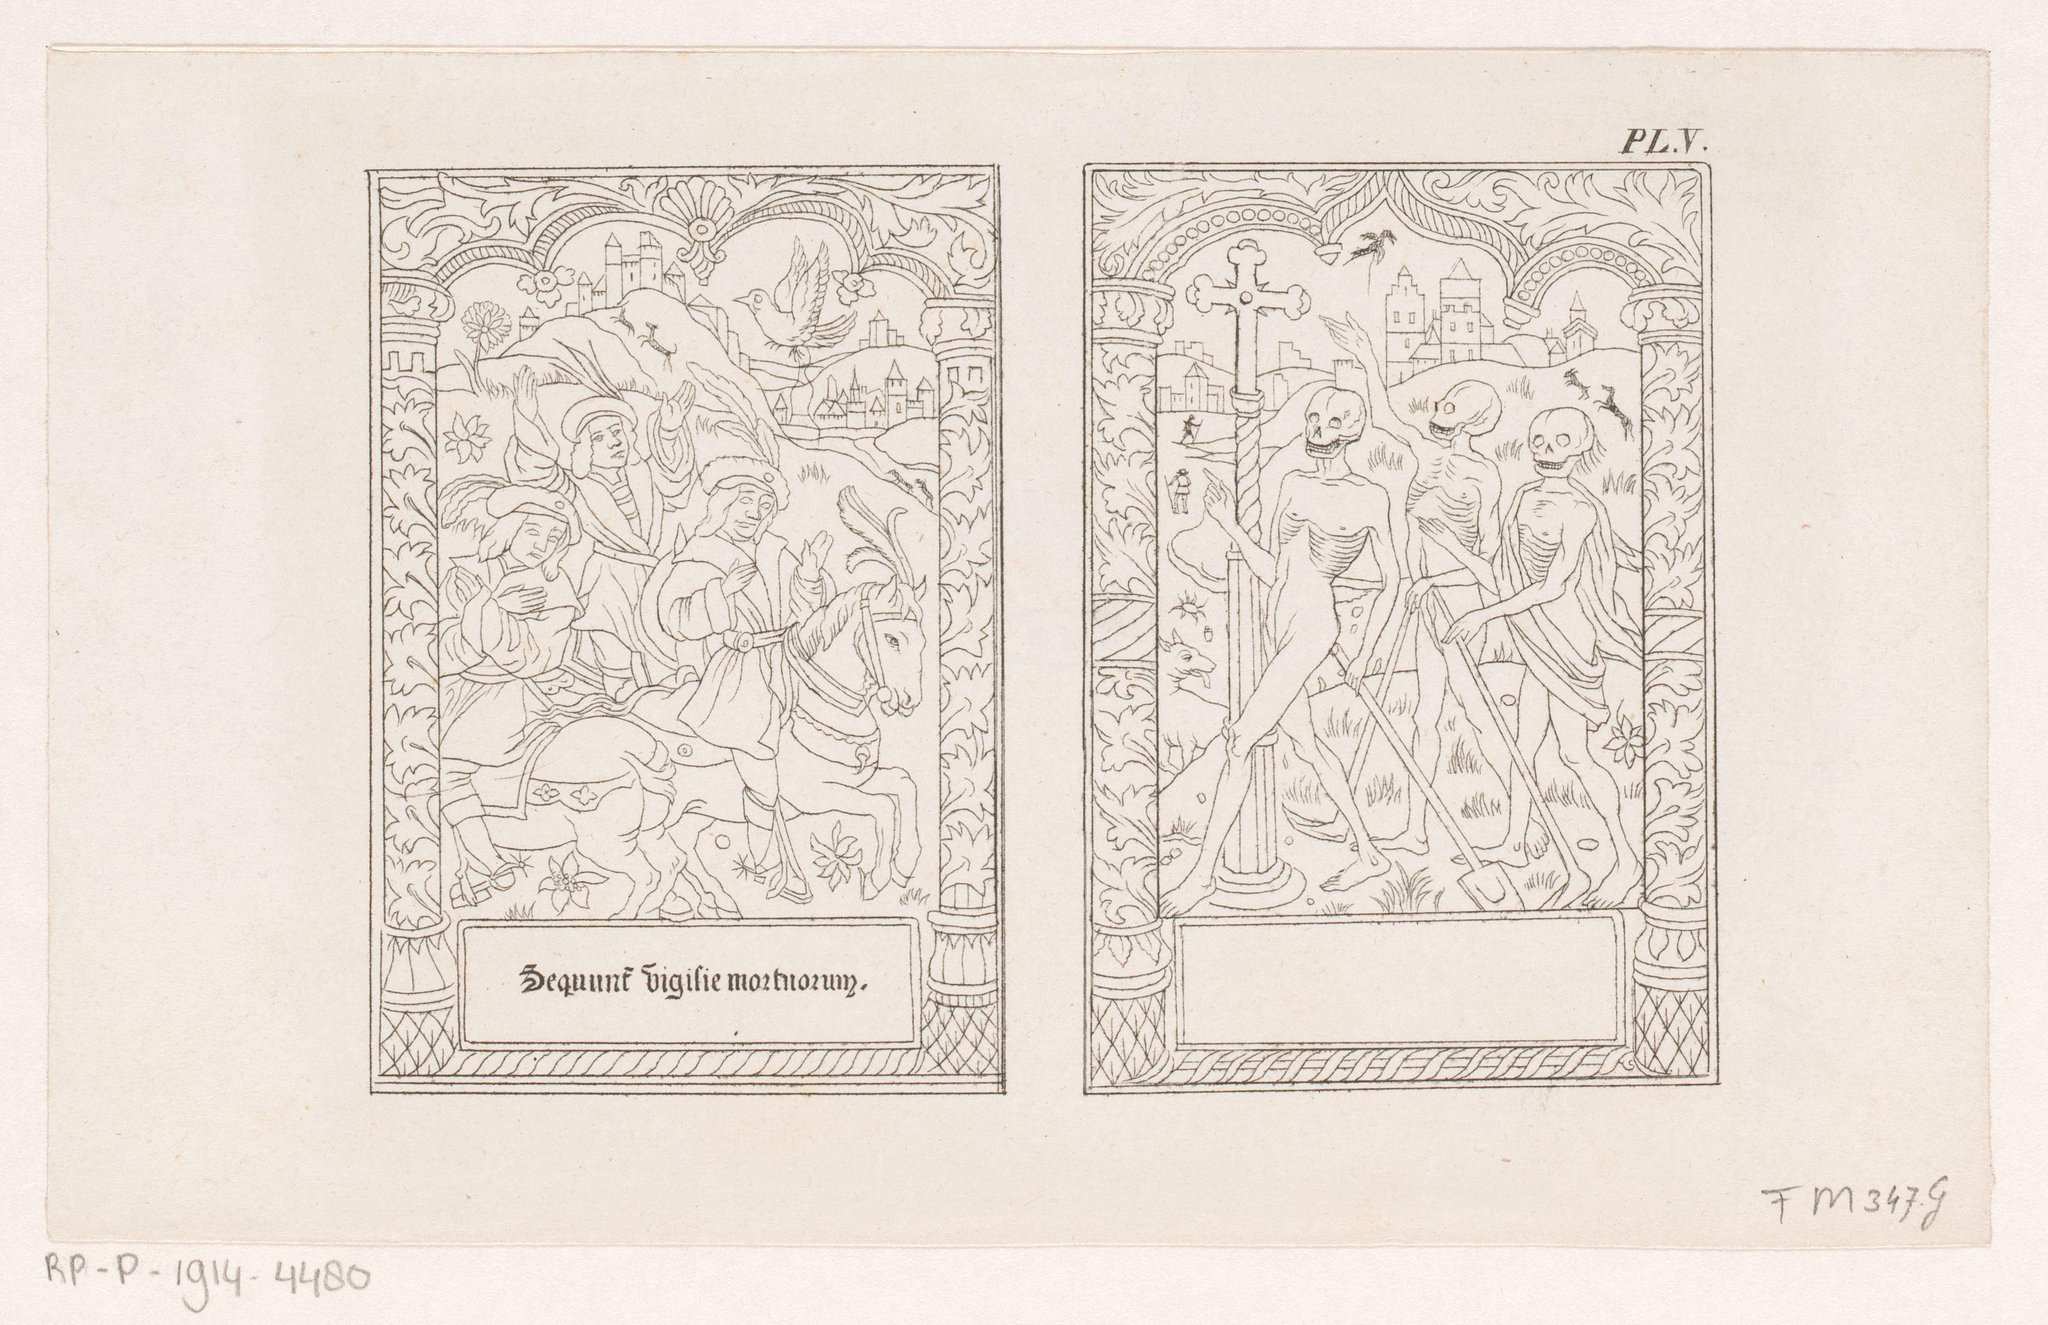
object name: print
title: Ruiters te paard en doden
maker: leendert springer (i)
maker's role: draughtsman, painter, print maker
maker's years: 1789-1871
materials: paper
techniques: lithograph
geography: leiden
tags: dance of death; death together with one or more human beings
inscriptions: collector's mark: Lugt 2228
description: Prent uit: Kist, N.C, 'Het humoristisch karakter der christelijke kunst in het tijdvak, hetwelk de kerkhervorming der XVIde eeuw heeft voorbereid; zigtbaar vooral in de kerkelijke architectuur en de doodendansen', Nederlandsch archief voor kerkelijke geschiedenis 4 (1844).